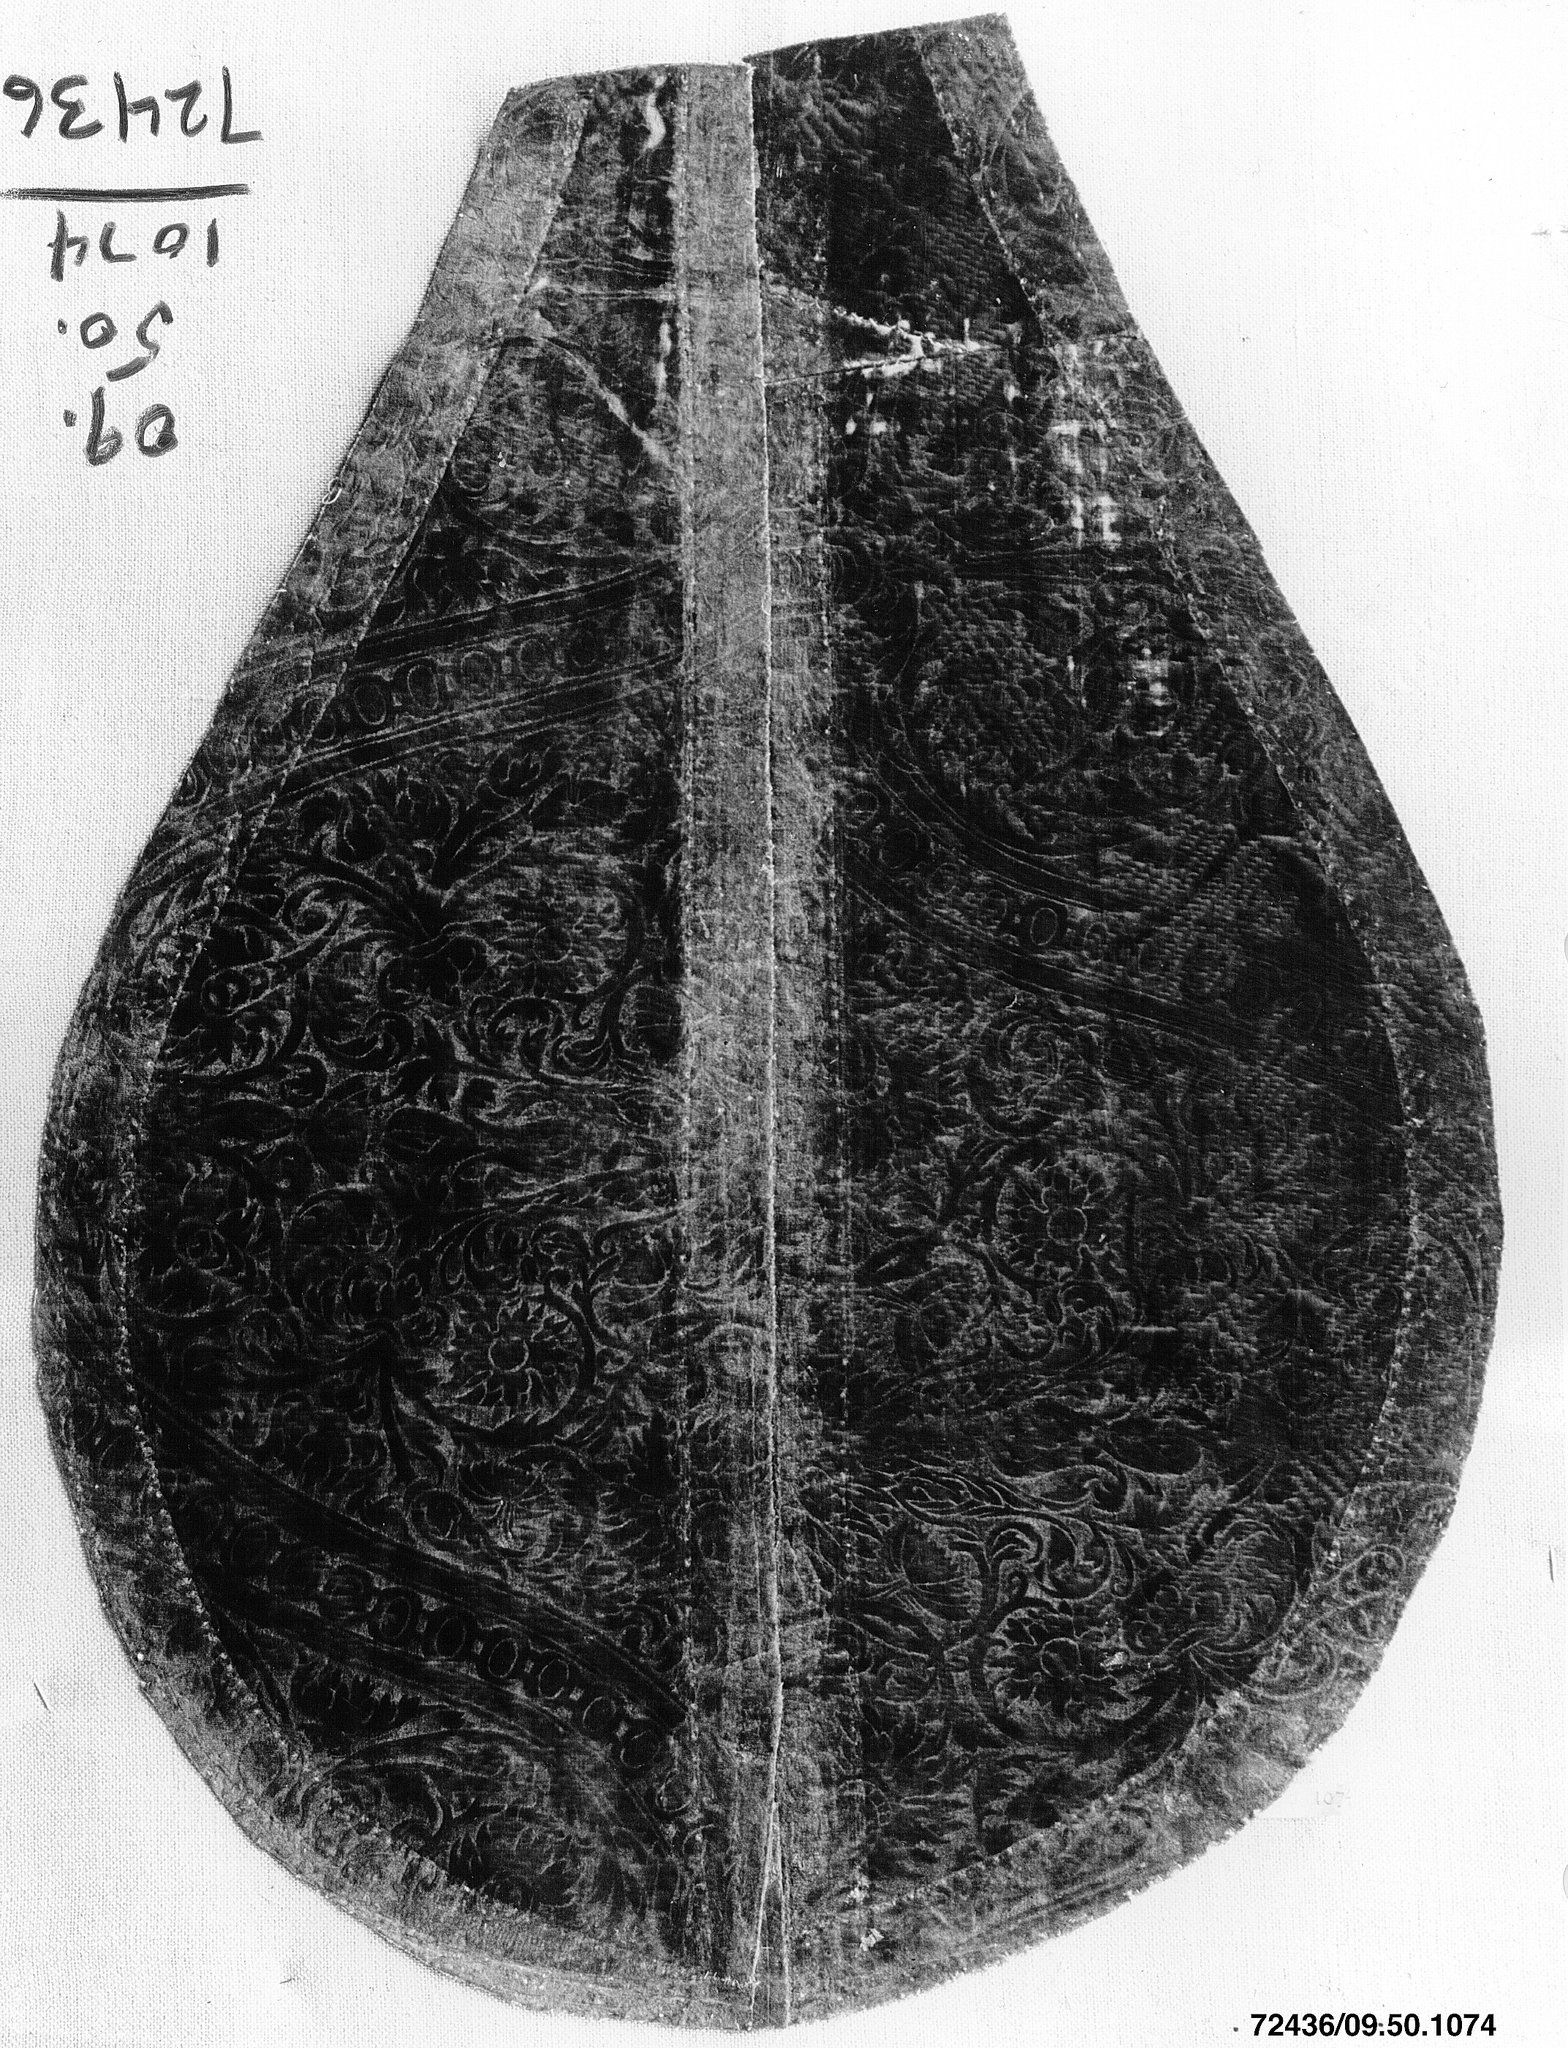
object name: piece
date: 1501-1700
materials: silk